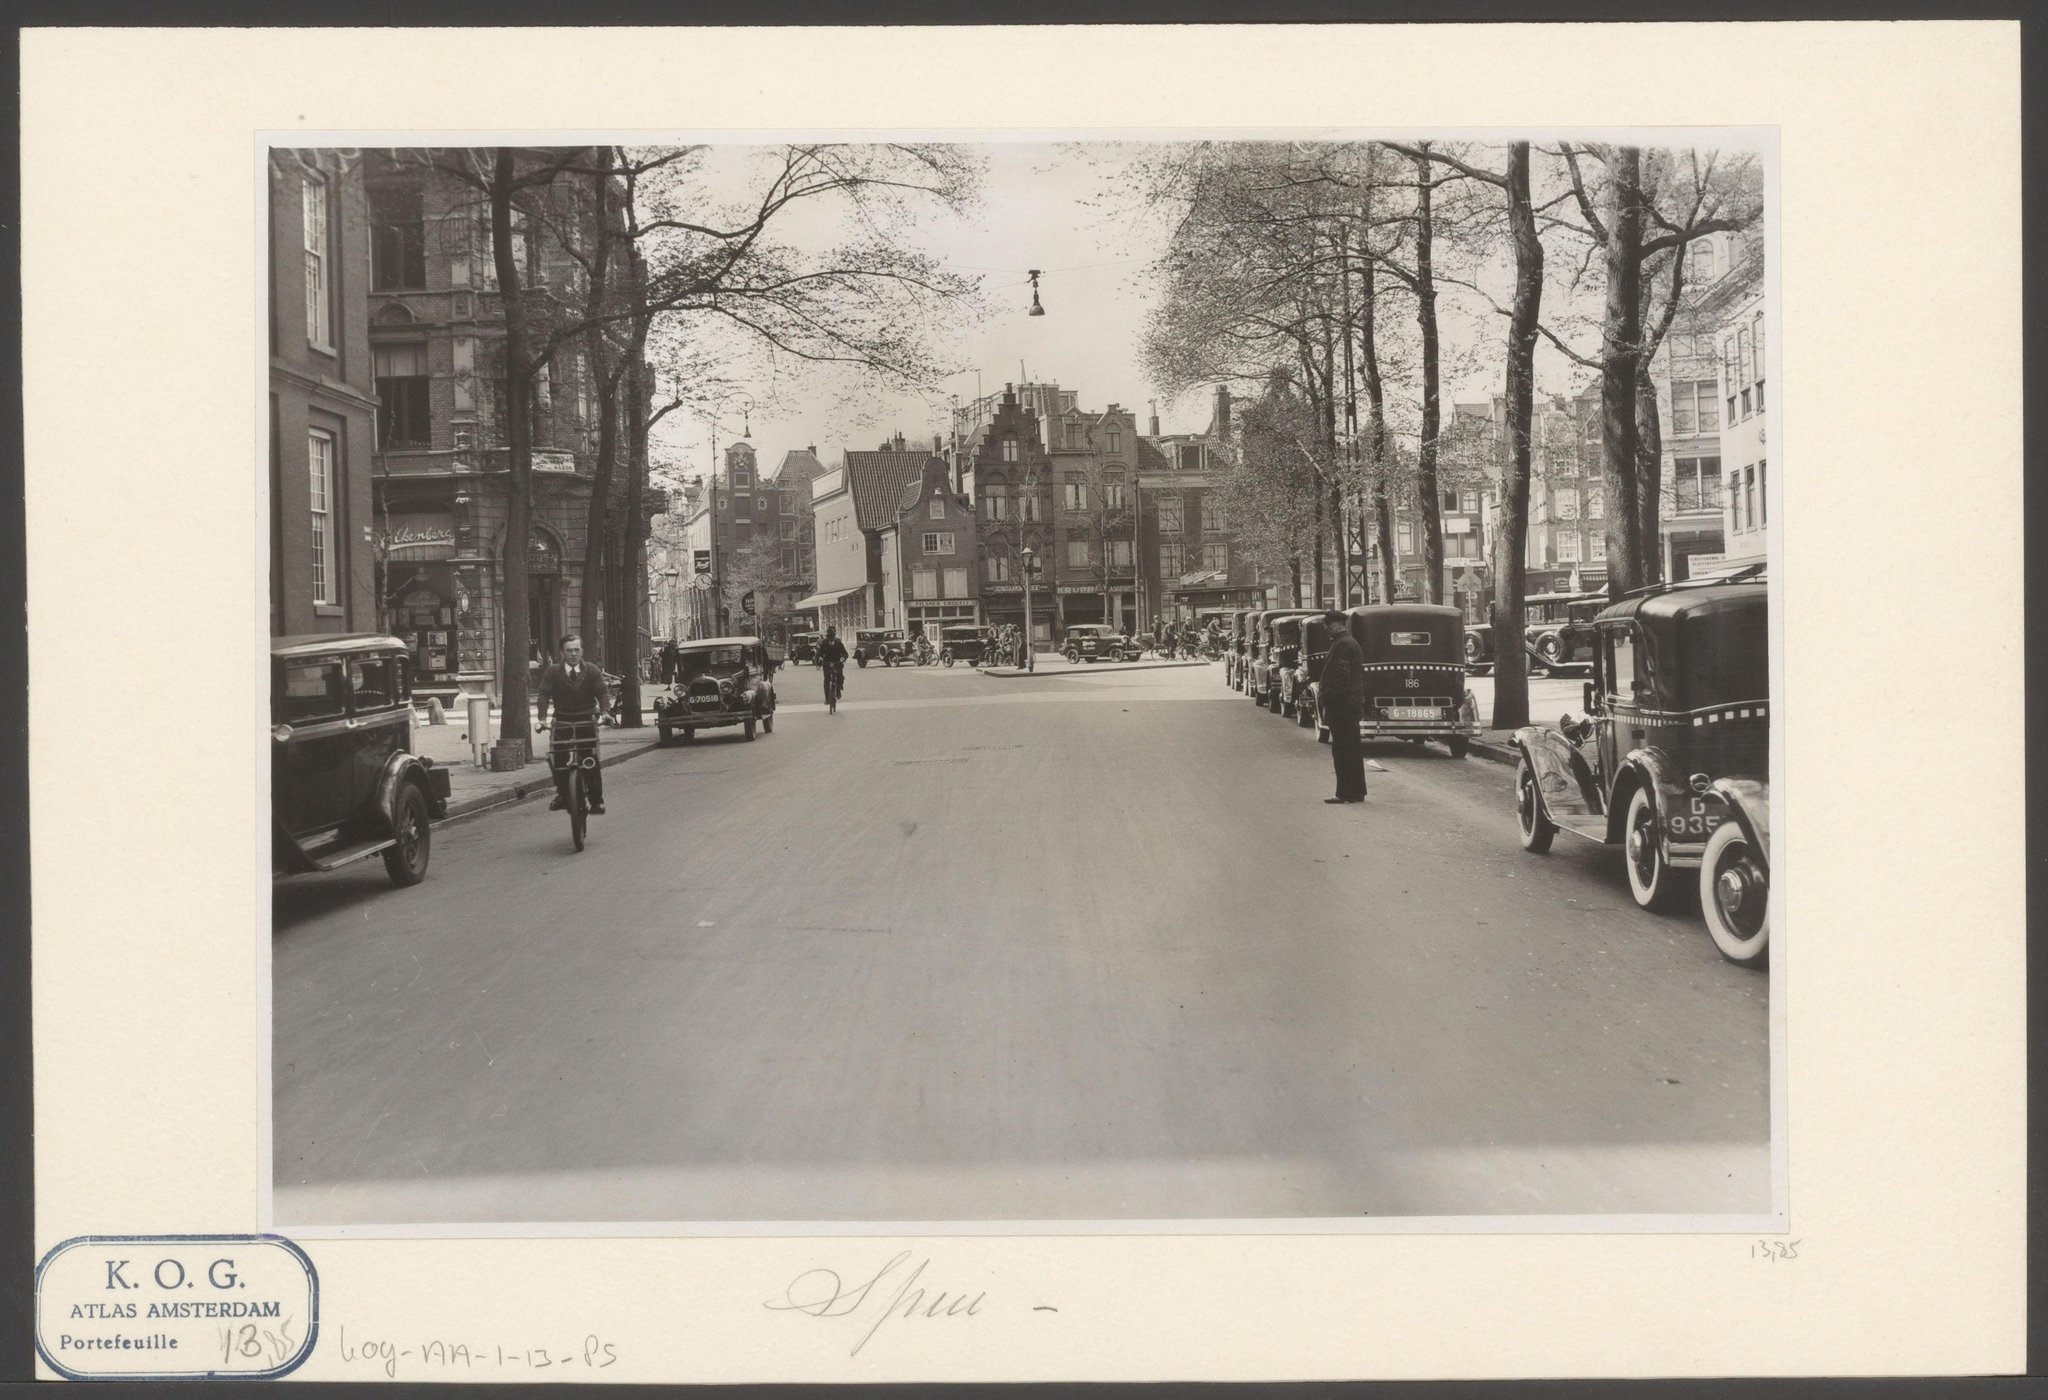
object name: photograph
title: Gezicht op het Spui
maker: Anonymous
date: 1880-1950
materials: paper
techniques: gelatin silver print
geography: amsterdam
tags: city-view in general; 'veduta', the usual house or row of houses, street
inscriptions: collector's mark: ‘13,85’ Lugt 1641b, inscription: ‘Spui-’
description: Onderwerpsrubriek binnen de Atlas Amsterdam: Slatuinenpad, Sloterkade, Slootstraat, Slijkstraat, Snoekjesgracht, Sophiapark, Spaarndammerdijk, Spiegelgracht, Spinhuissteeg, Spui, Spuistraat (ook lage Erf), Staalstraat, Stadhouderskade, Steenpad, Stroomarkt.